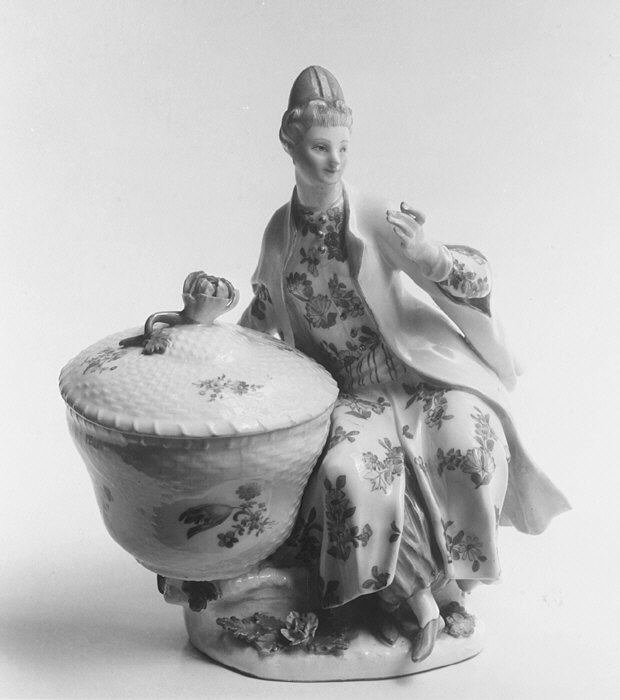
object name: figure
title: Turkish woman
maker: meissen manufactory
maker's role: manufactory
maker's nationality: german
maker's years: 1710-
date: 1750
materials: hard paste porcelain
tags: women,flowers